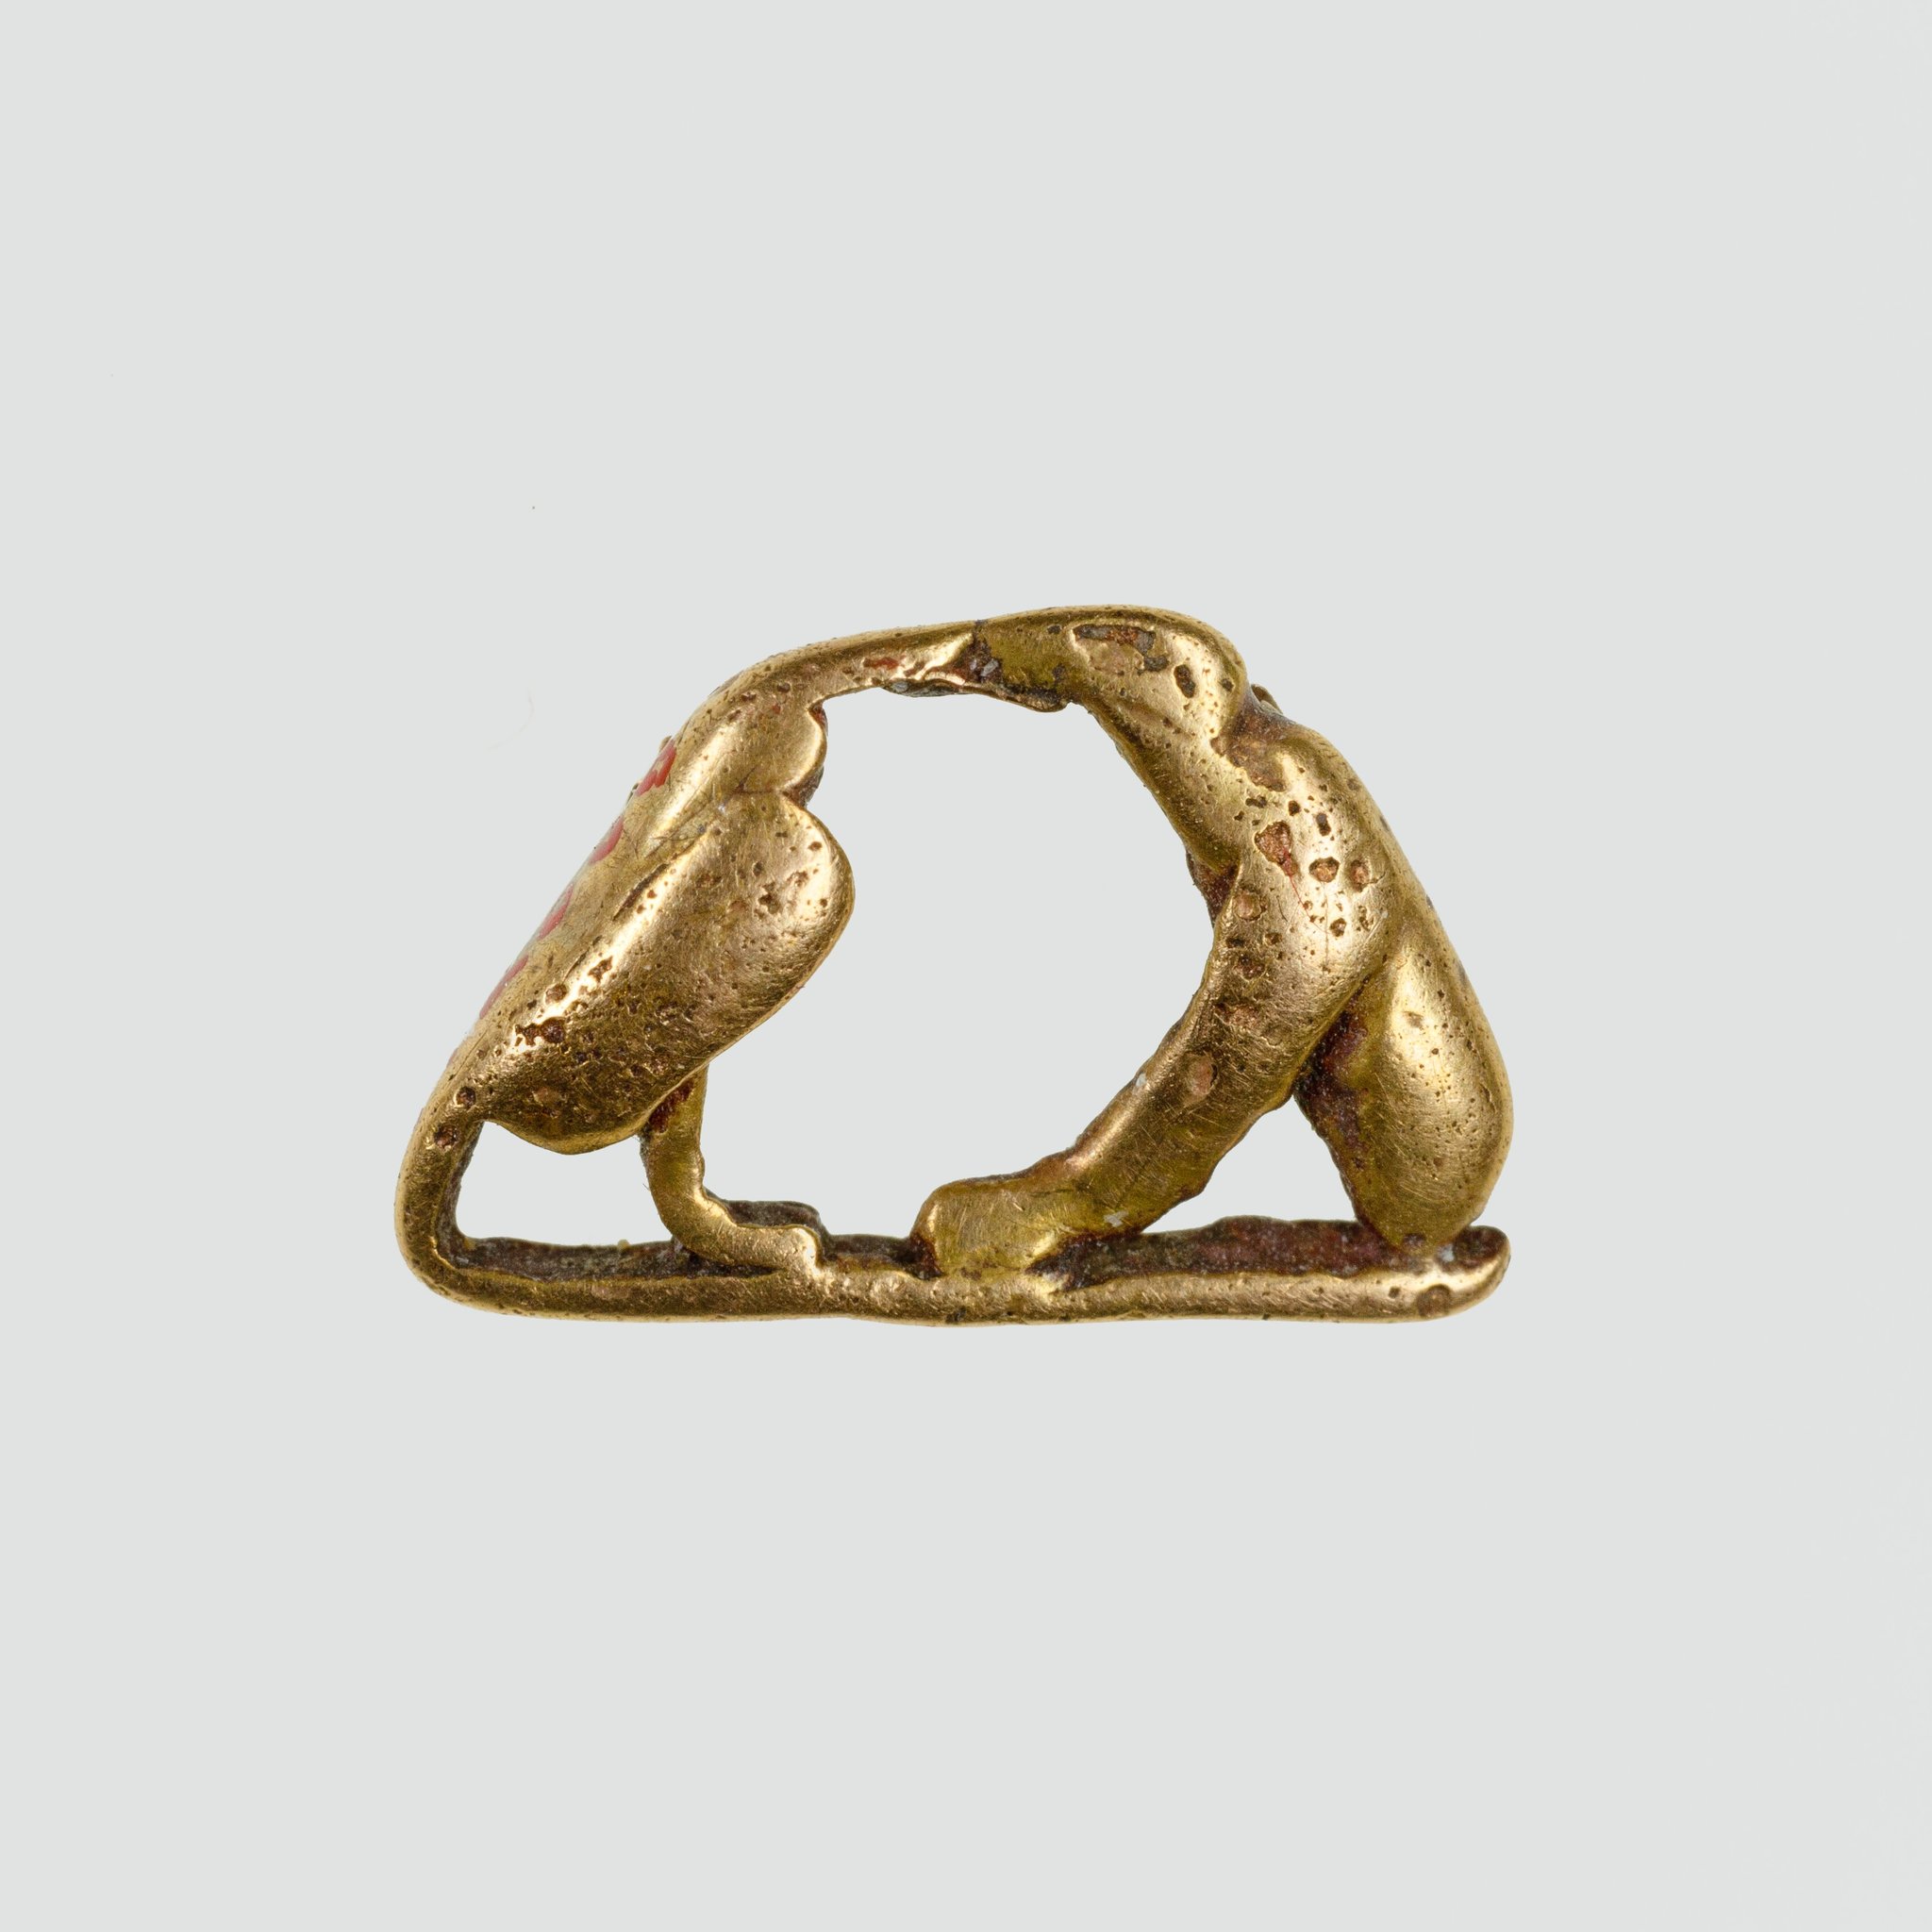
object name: vulture and falcon amulet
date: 2150-2050 BCE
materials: gold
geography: egypt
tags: falcons